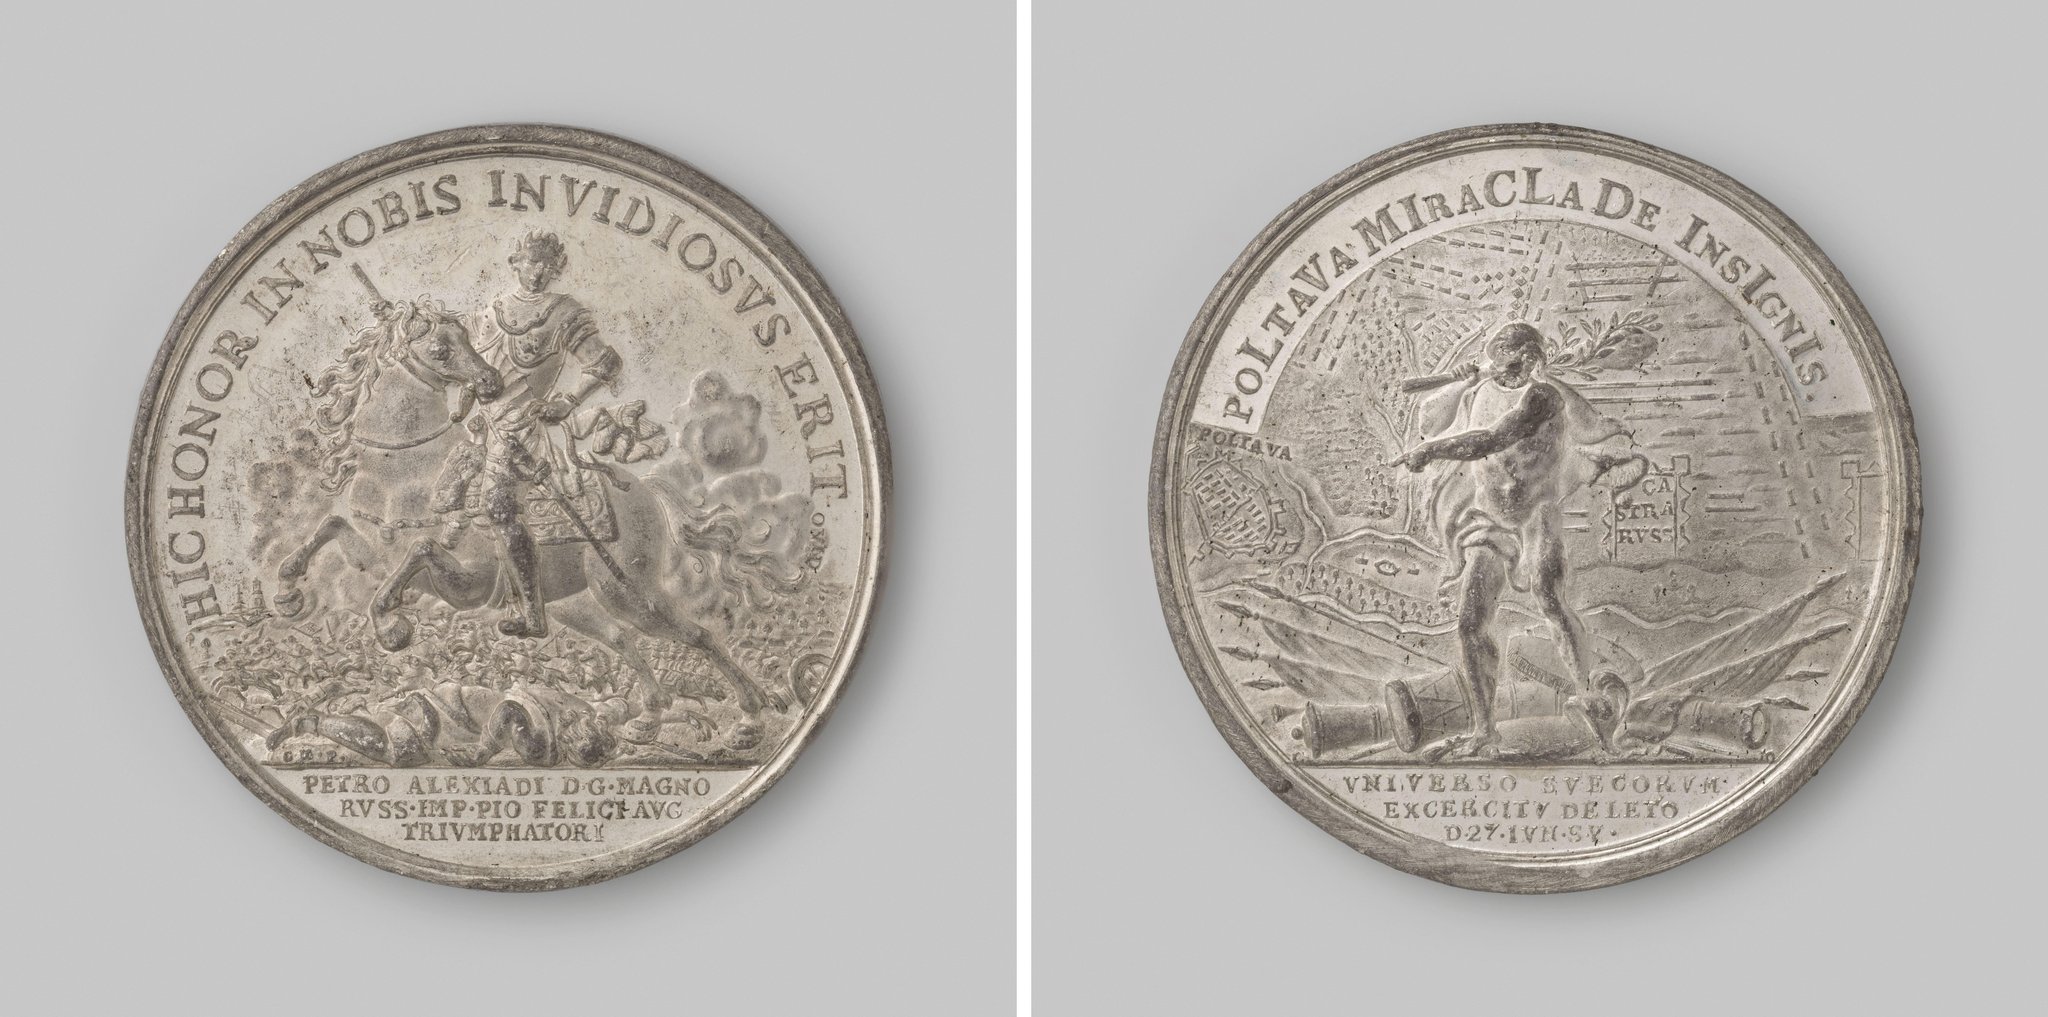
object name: history medal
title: Overwinning van Rusland op Zweden bij Pultawa (Poltava) 1709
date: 1709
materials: tin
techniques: striking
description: Tinnen penning, op de voorzijde Tsaar Peter te paard naar links rijdend over een gevallen vijand, op de achtergrond vechtende soldaten, met omschrift en afsnedetekst, op de keerzijde Hercules met knots lopend te midden van militaire attributen, op de achtergrond de plattegrond van Pultawa, met omschrift en afsnedetekst.